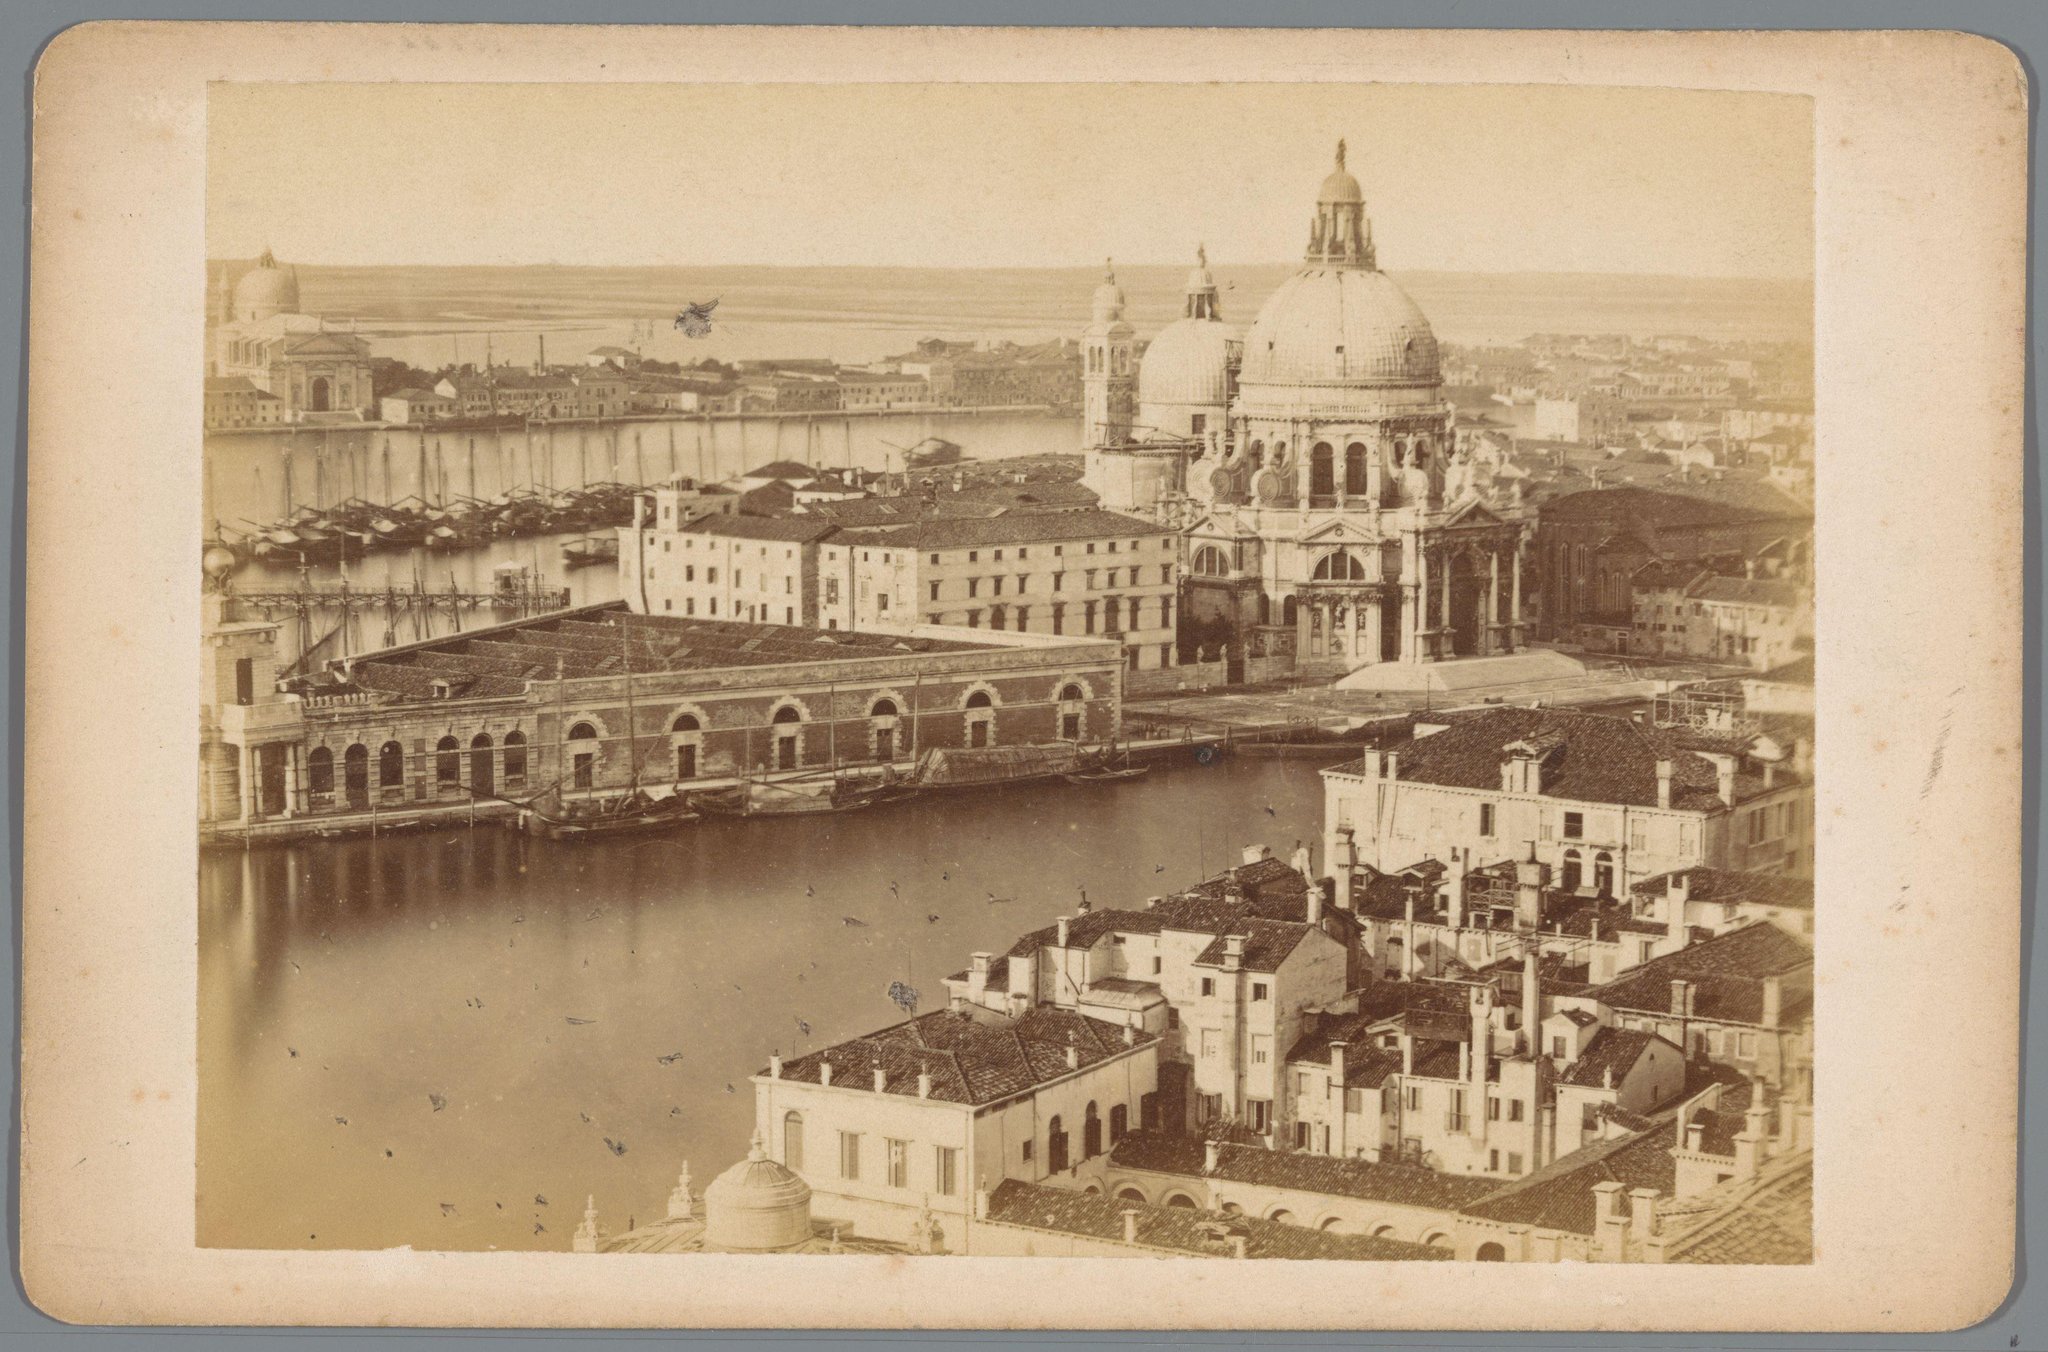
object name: cabinet photograph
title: Gezicht op Venetië met de Santa Maria della Salute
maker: Anonymous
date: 1860-1880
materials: cardboard, photographic support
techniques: albumen print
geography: venice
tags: city-view, and landscape with man-made constructions, church (exterior), venice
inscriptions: inscription: ‘Panorama’, name: ‘Vosmaer’